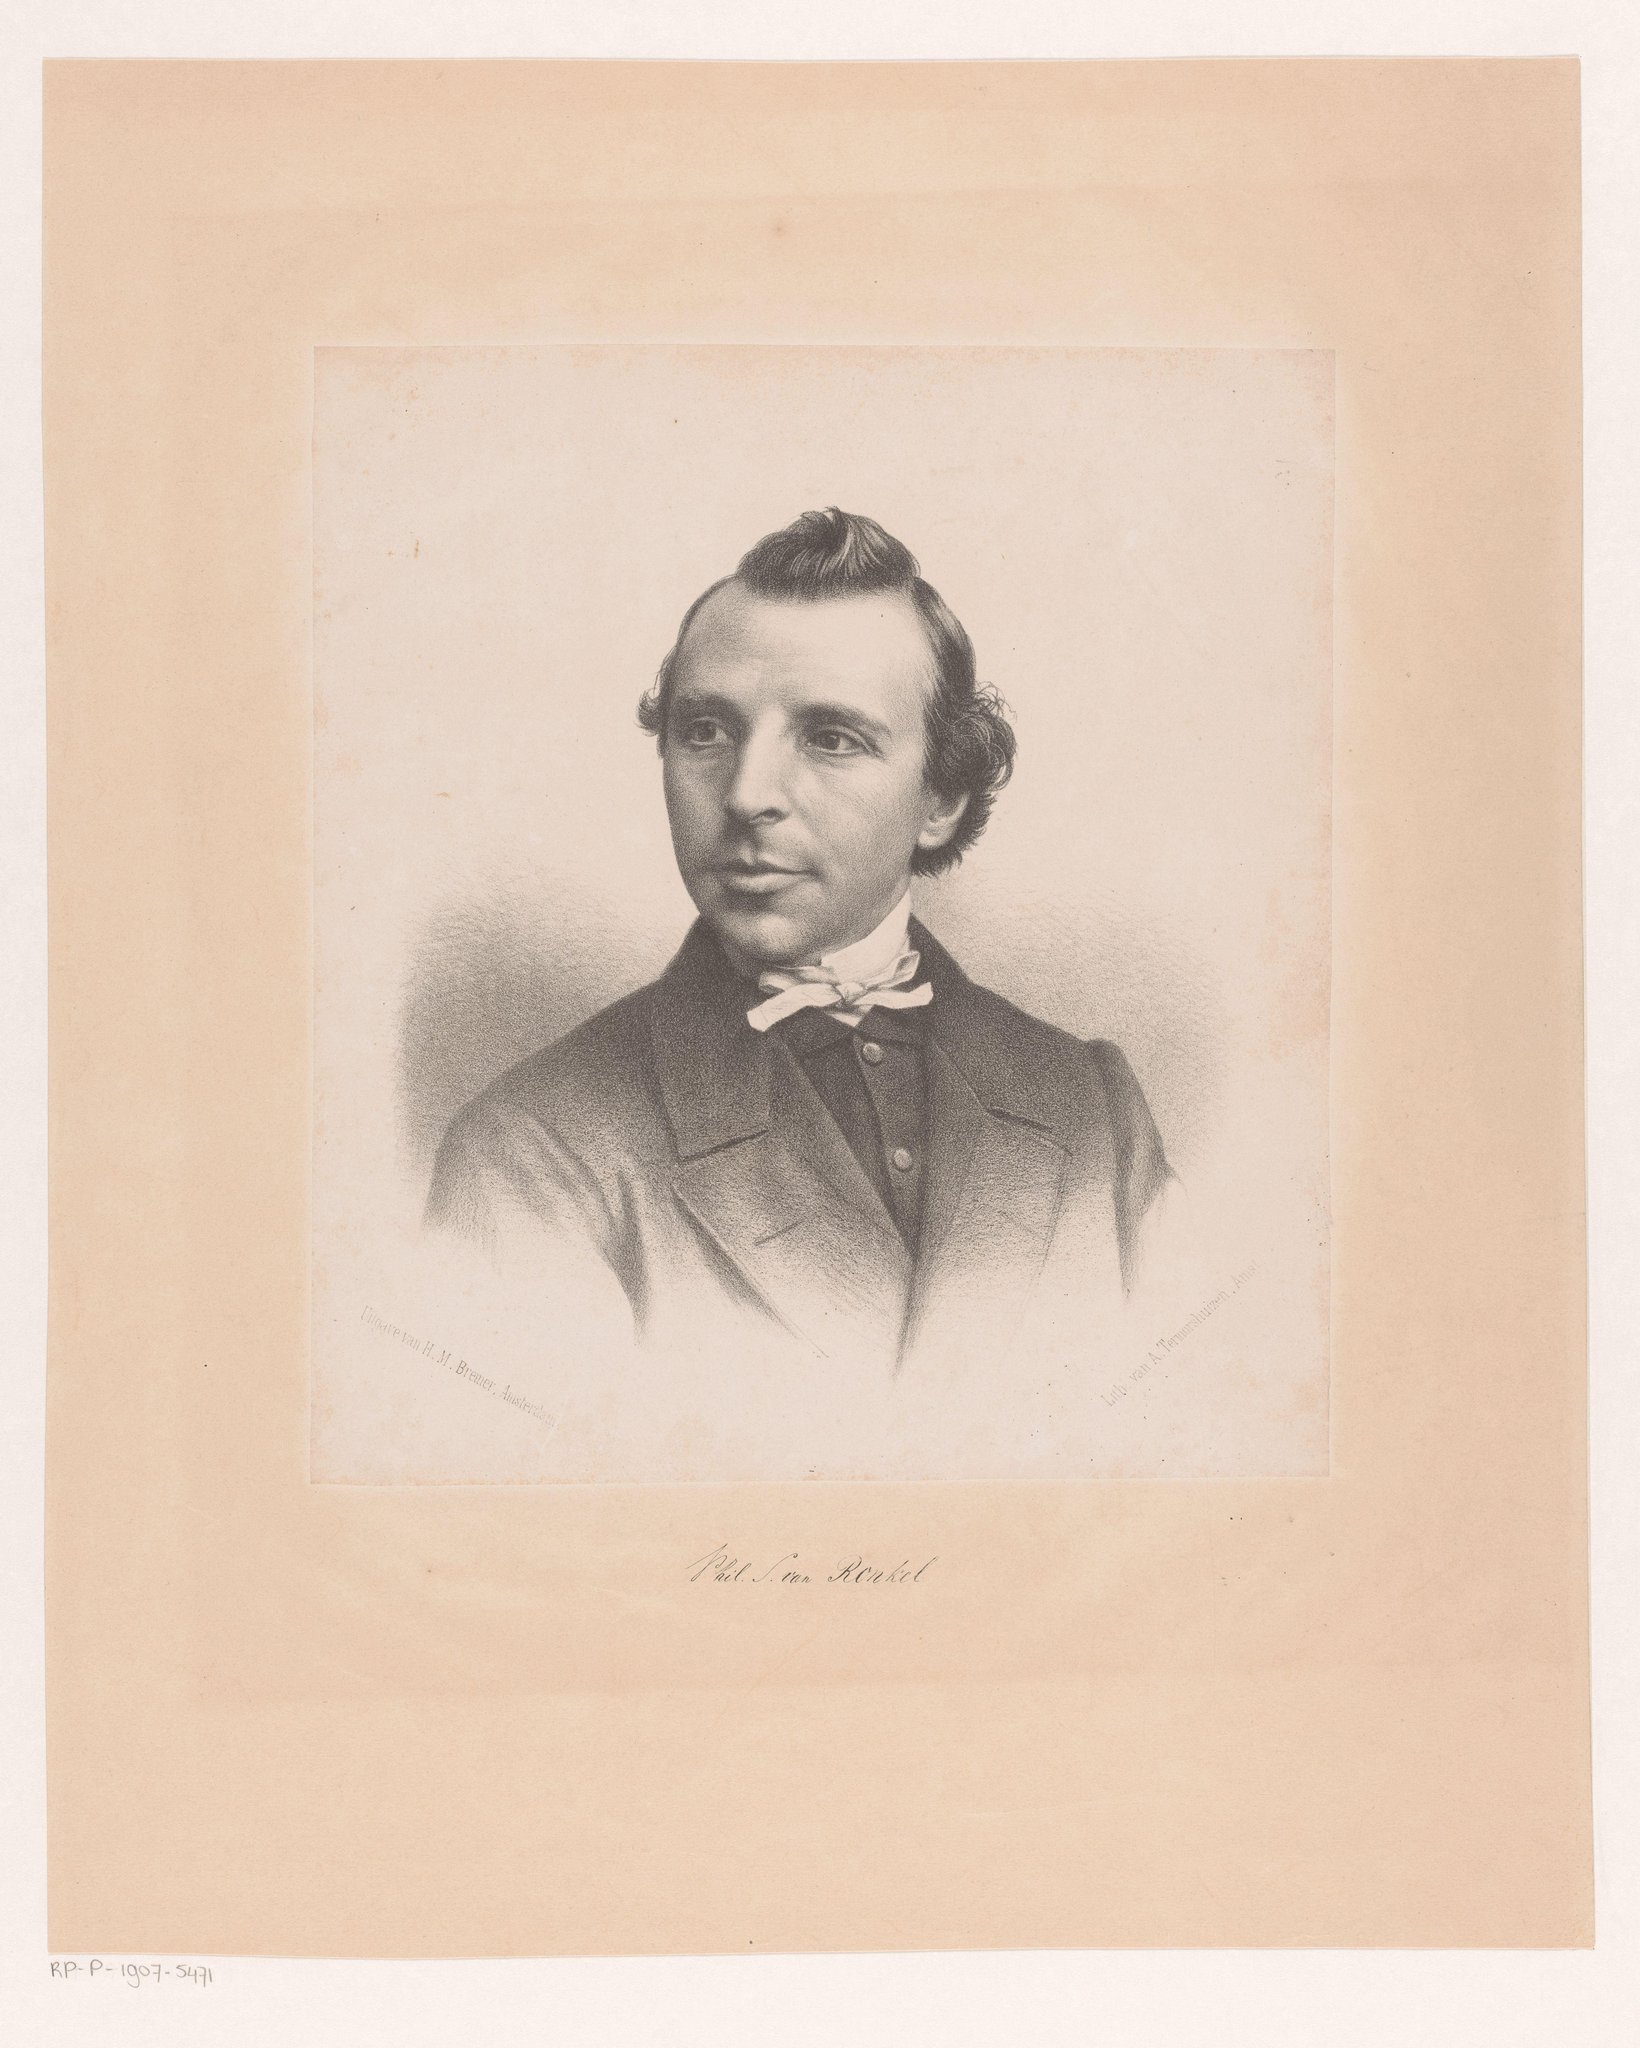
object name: print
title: Portret van Philippus Samuel van Ronkel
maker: h.m. bremer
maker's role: publisher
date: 1876-1883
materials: paper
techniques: lithograph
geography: amsterdam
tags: leiden, historical persons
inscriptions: collector's mark: Lugt 2228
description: Onder het portret de signatuur van de geportretteerde.